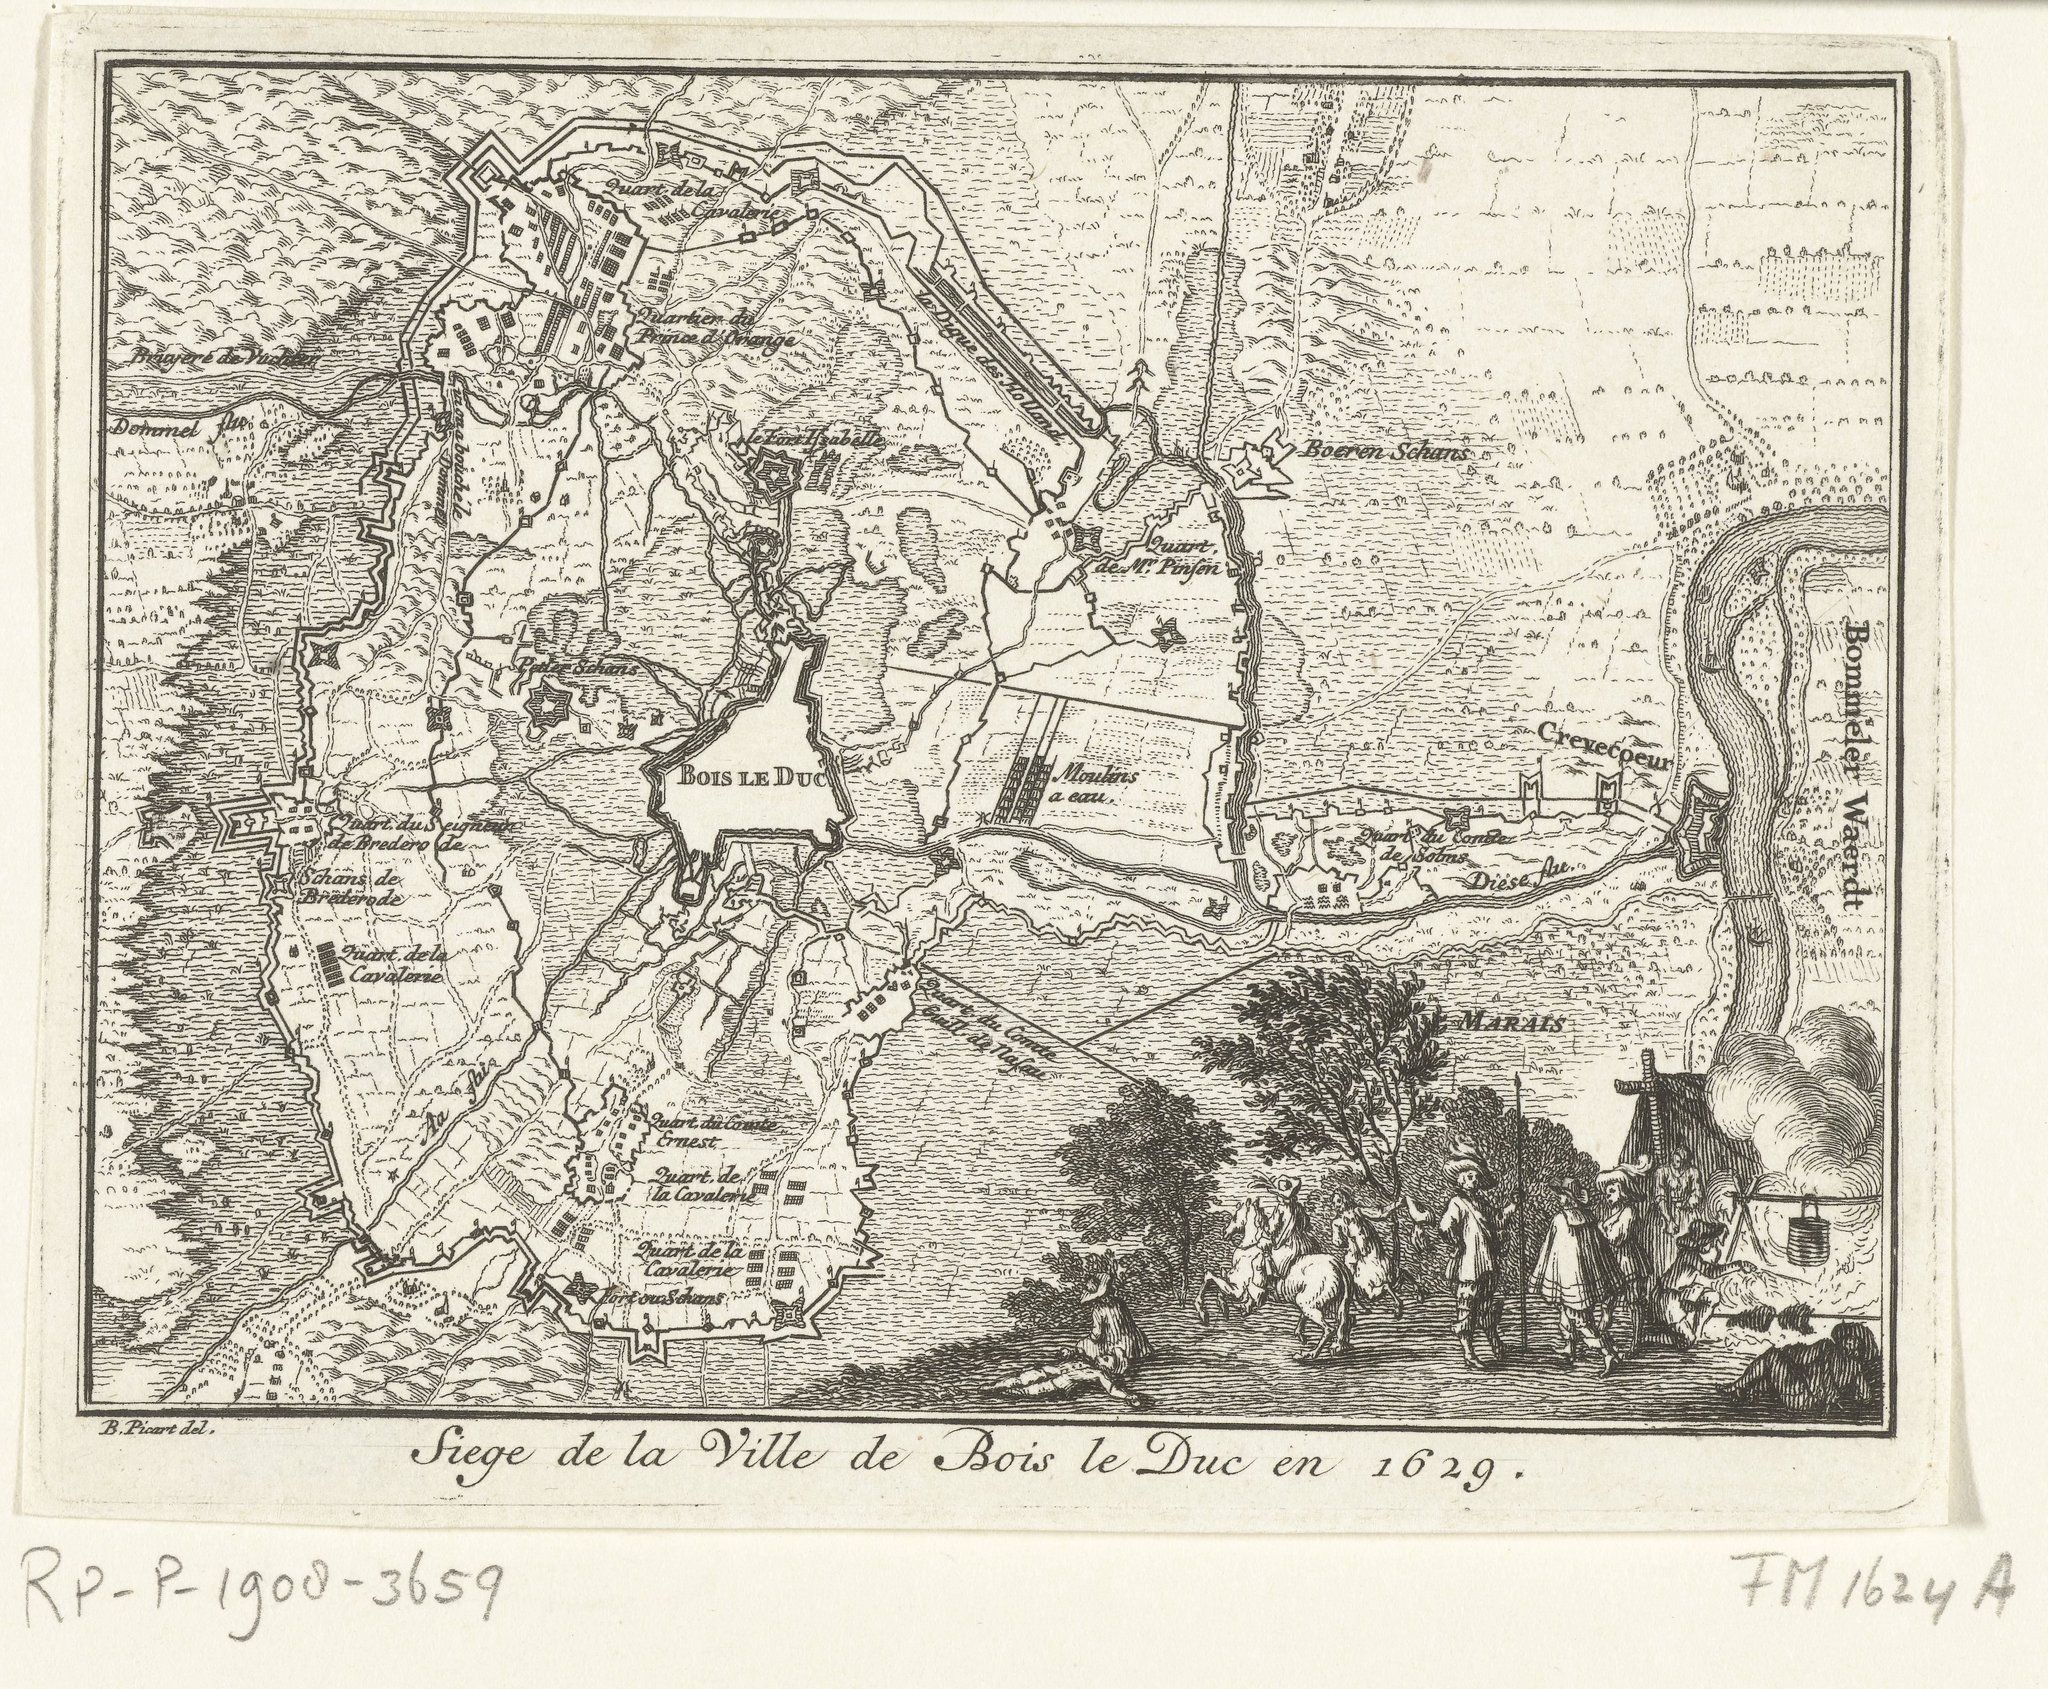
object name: history print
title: Kaart van het beleg van Den Bosch door Frederik Hendrik, 1629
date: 1683-1733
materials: paper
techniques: etching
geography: northern netherlands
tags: delft, frederick henry (prince of orange), maps of separate countries or regions, siege, position war, den bosch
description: Kaart van Den Bosch en omgeving tijdens de omsingeling en het beleg door het Staatse leger onder Frederik Hendrik, van 1 mei tot 17 september 1629. Rechts op een voorgrond een scène uit het dagelijkse leven in het legerkamp.